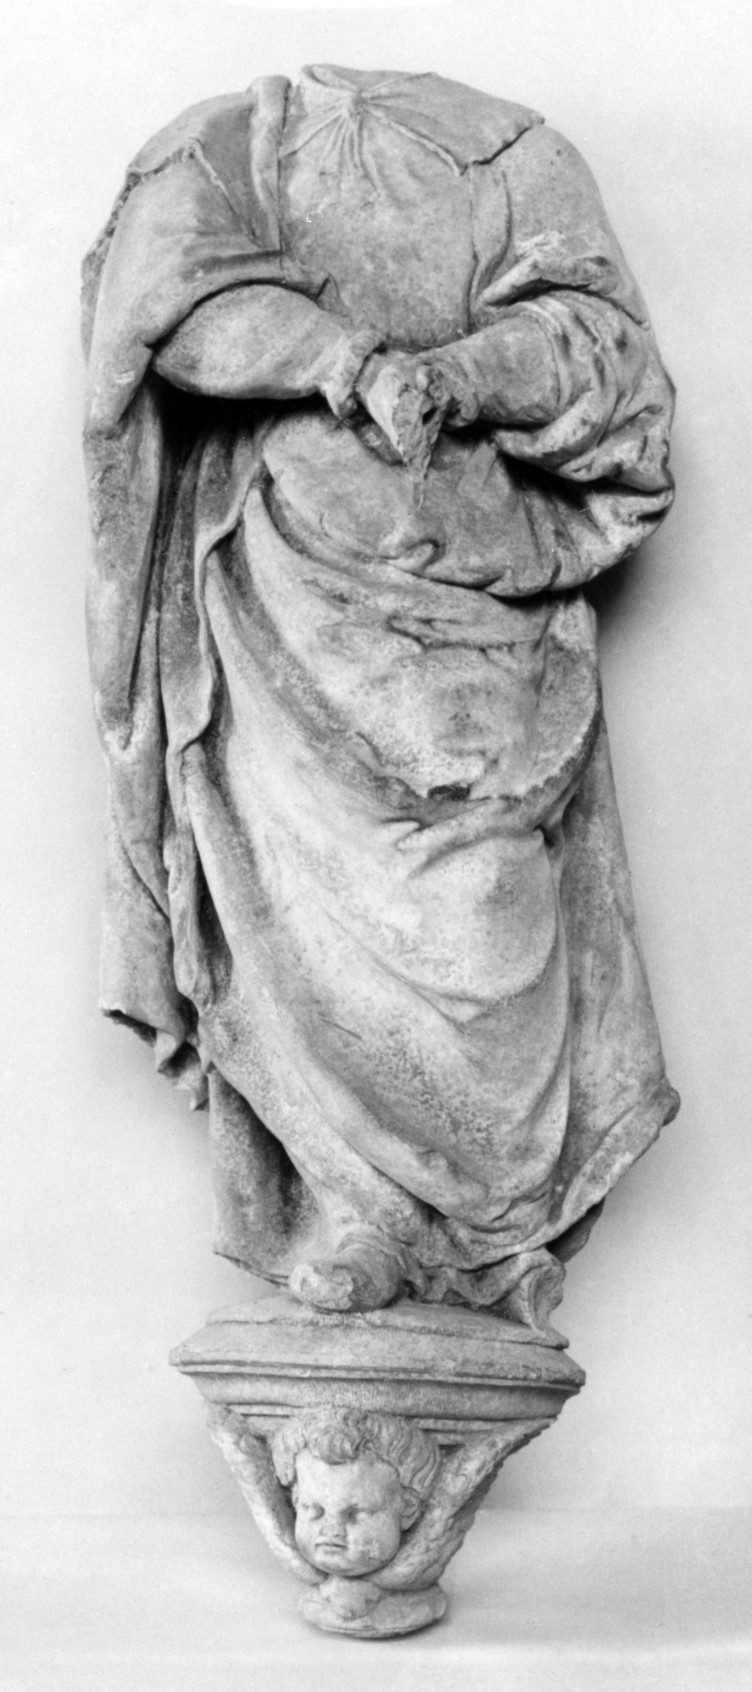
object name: statuette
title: Female statuette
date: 1550-1560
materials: stone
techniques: polychrome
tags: heads,women